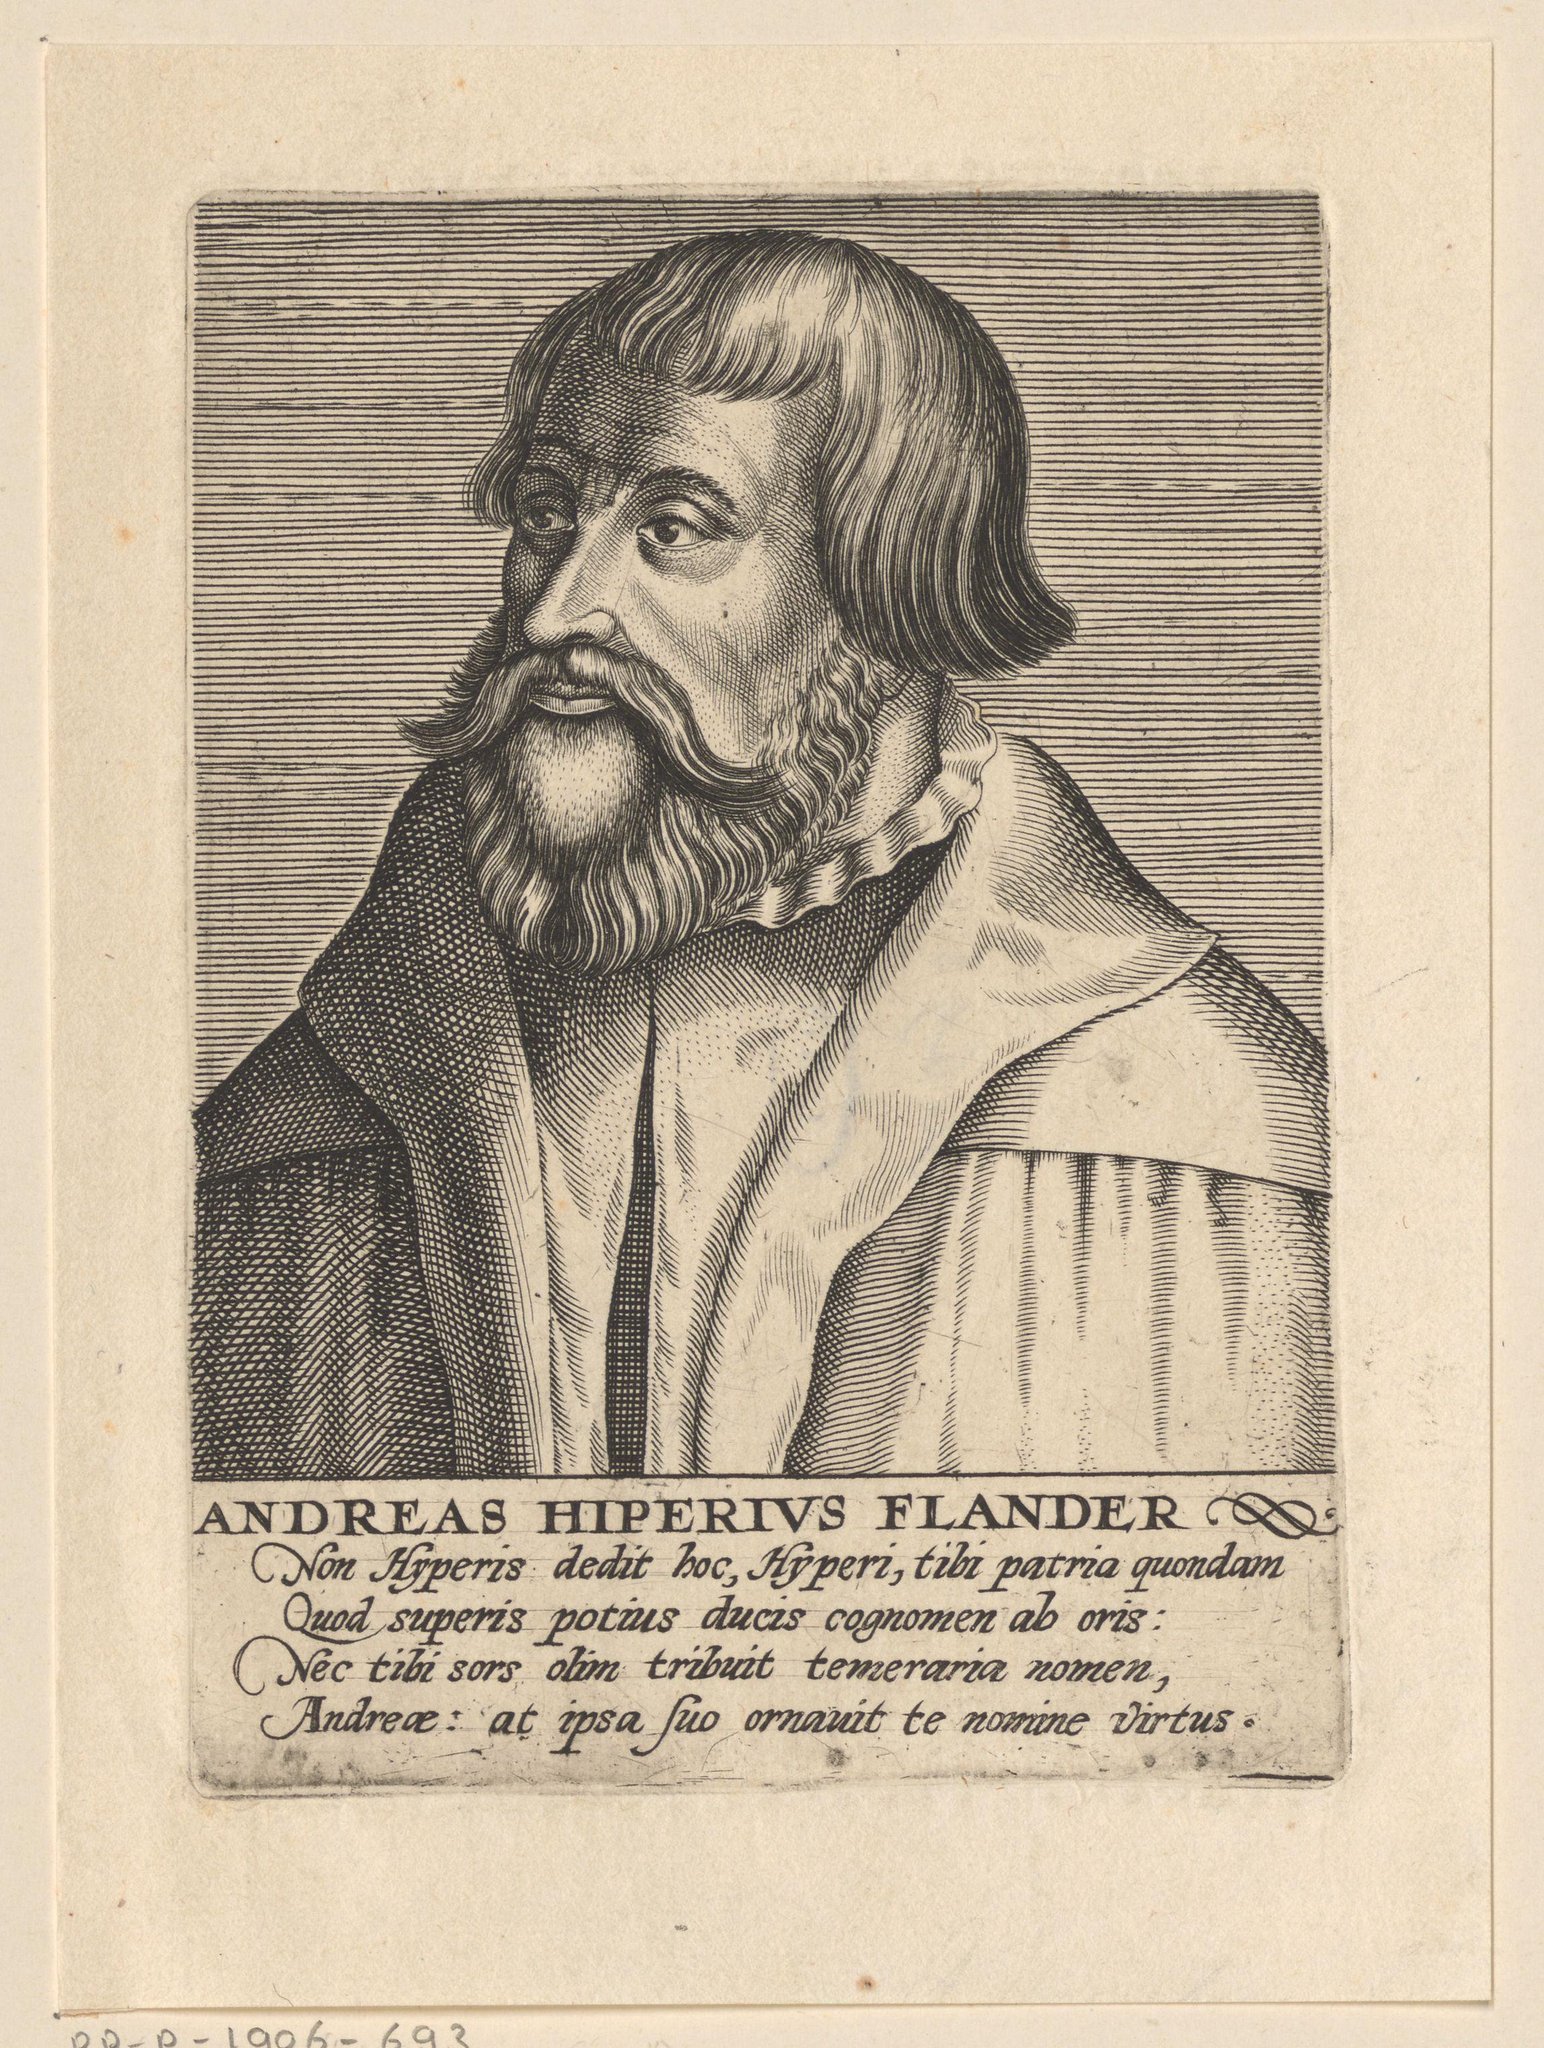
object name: print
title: Portret van Andreas Hyperius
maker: Anonymous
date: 1600-1649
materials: paper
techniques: engraving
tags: theologian, historical persons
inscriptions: collector's mark: Lugt 2228